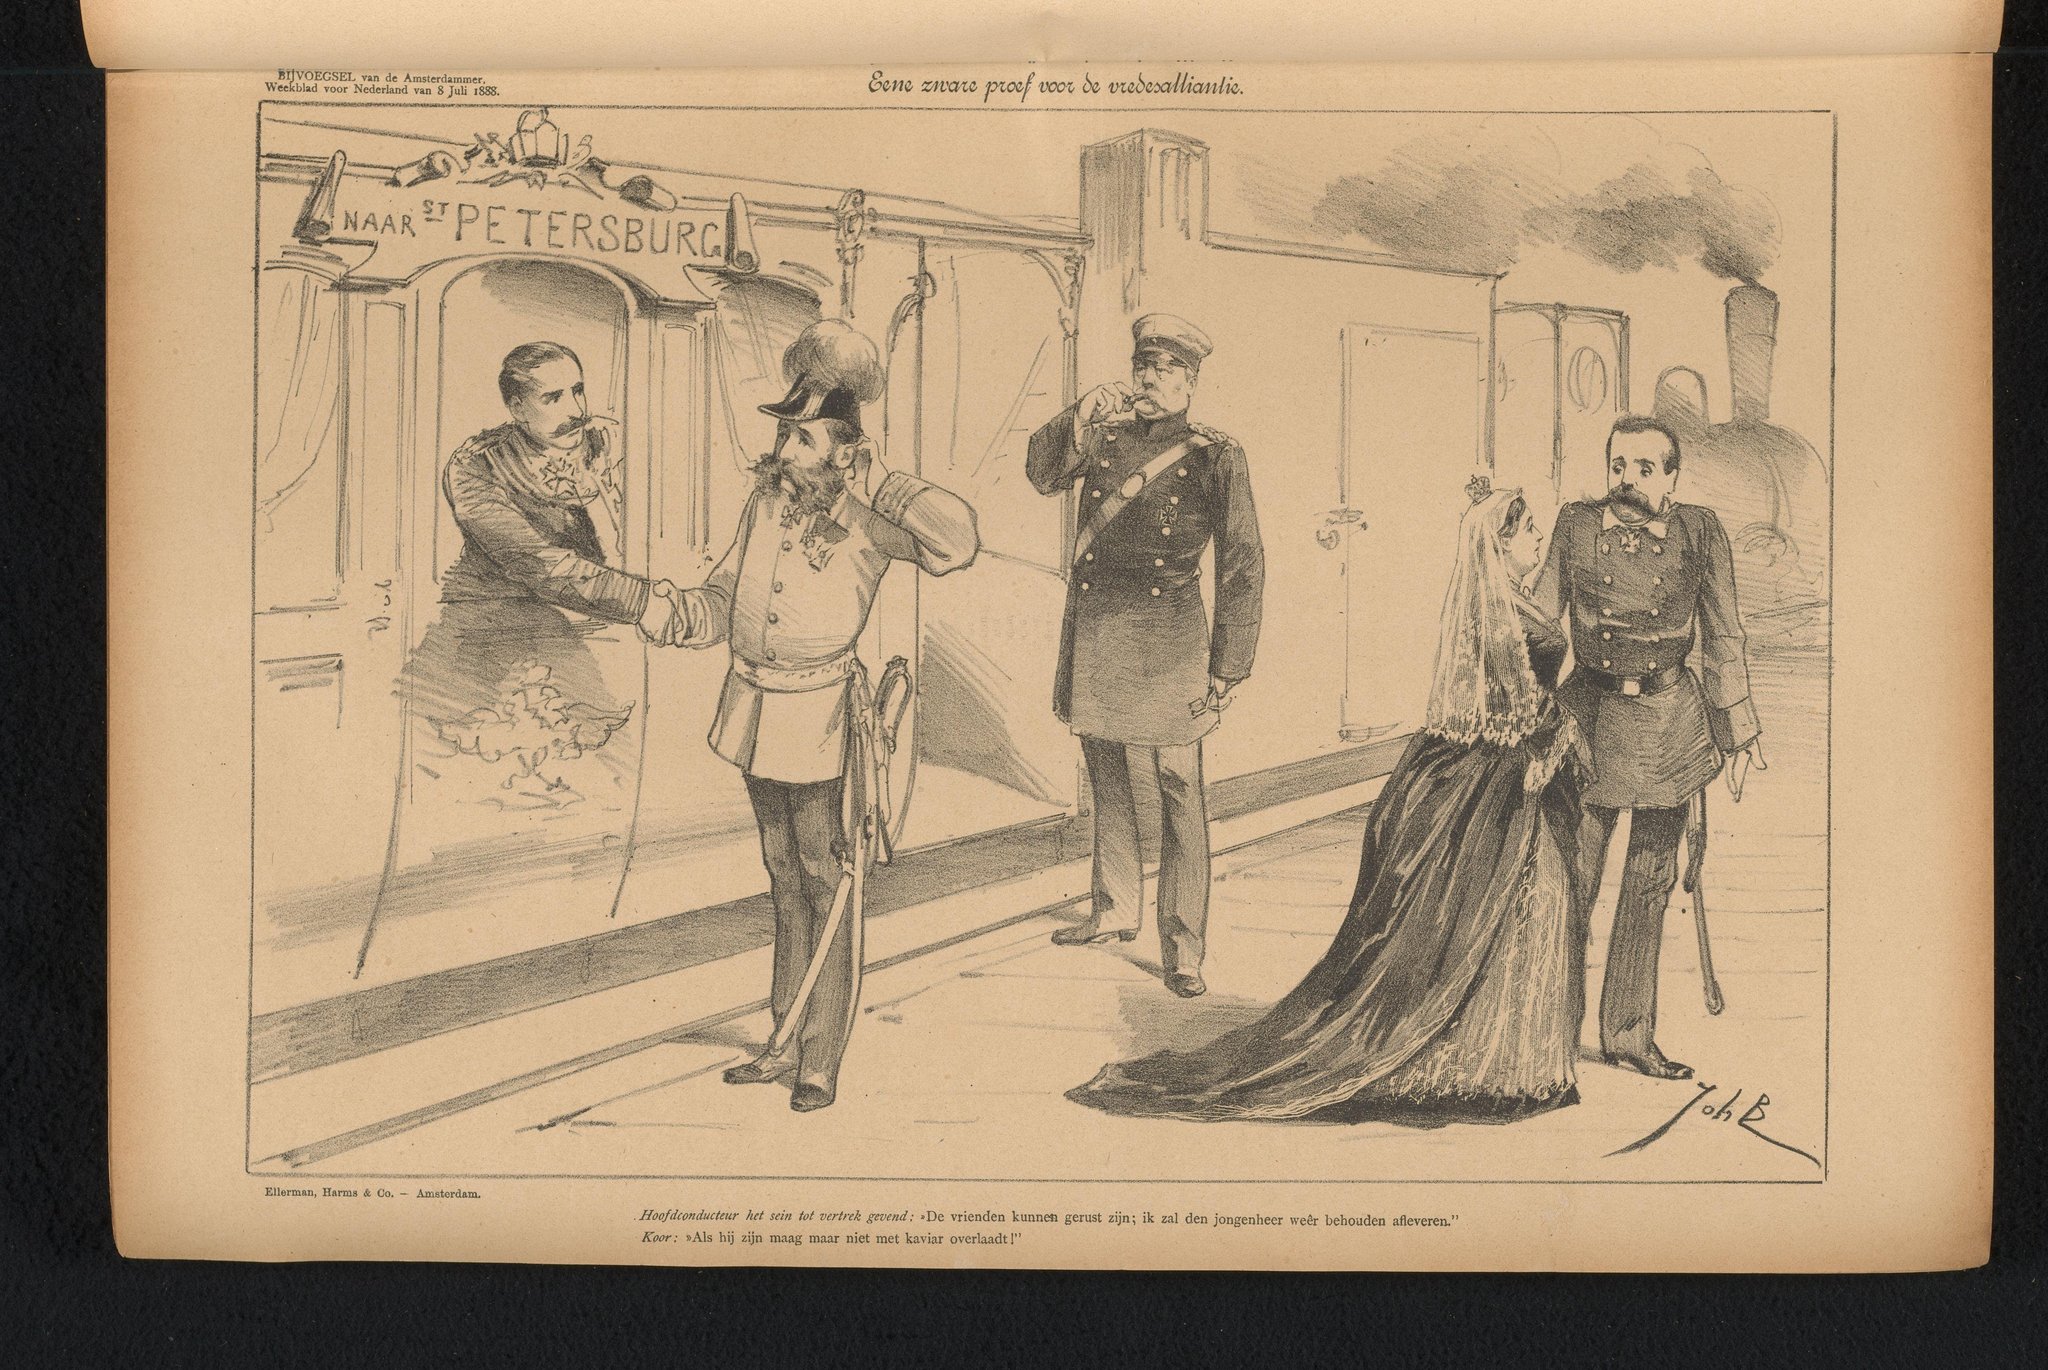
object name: cartoon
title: Eene zware proef voor de vredesalliantie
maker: johan braakensiek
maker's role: draughtsman, print maker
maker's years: 1858-1940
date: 1888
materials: paper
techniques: lithograph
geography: amsterdam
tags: victoria (koningin van het verenigd koninkrijk en keizerin van india), vienna, wilhelm ii (keizer van duitsland), passenger train, platform (railway, tramway), political caricatures and satires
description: Kanselier Otto von Bismarck als hoofdconducteur van de trein die de Duitse keizer Wilhelm II naar Sint Petersburg brengt. Hij schudt de hand van keizer Frans Jozef I Karel van Oostenrijk. Op het perron ook de Britse koningin Victoria en de Italiaanse koning Umberto I.